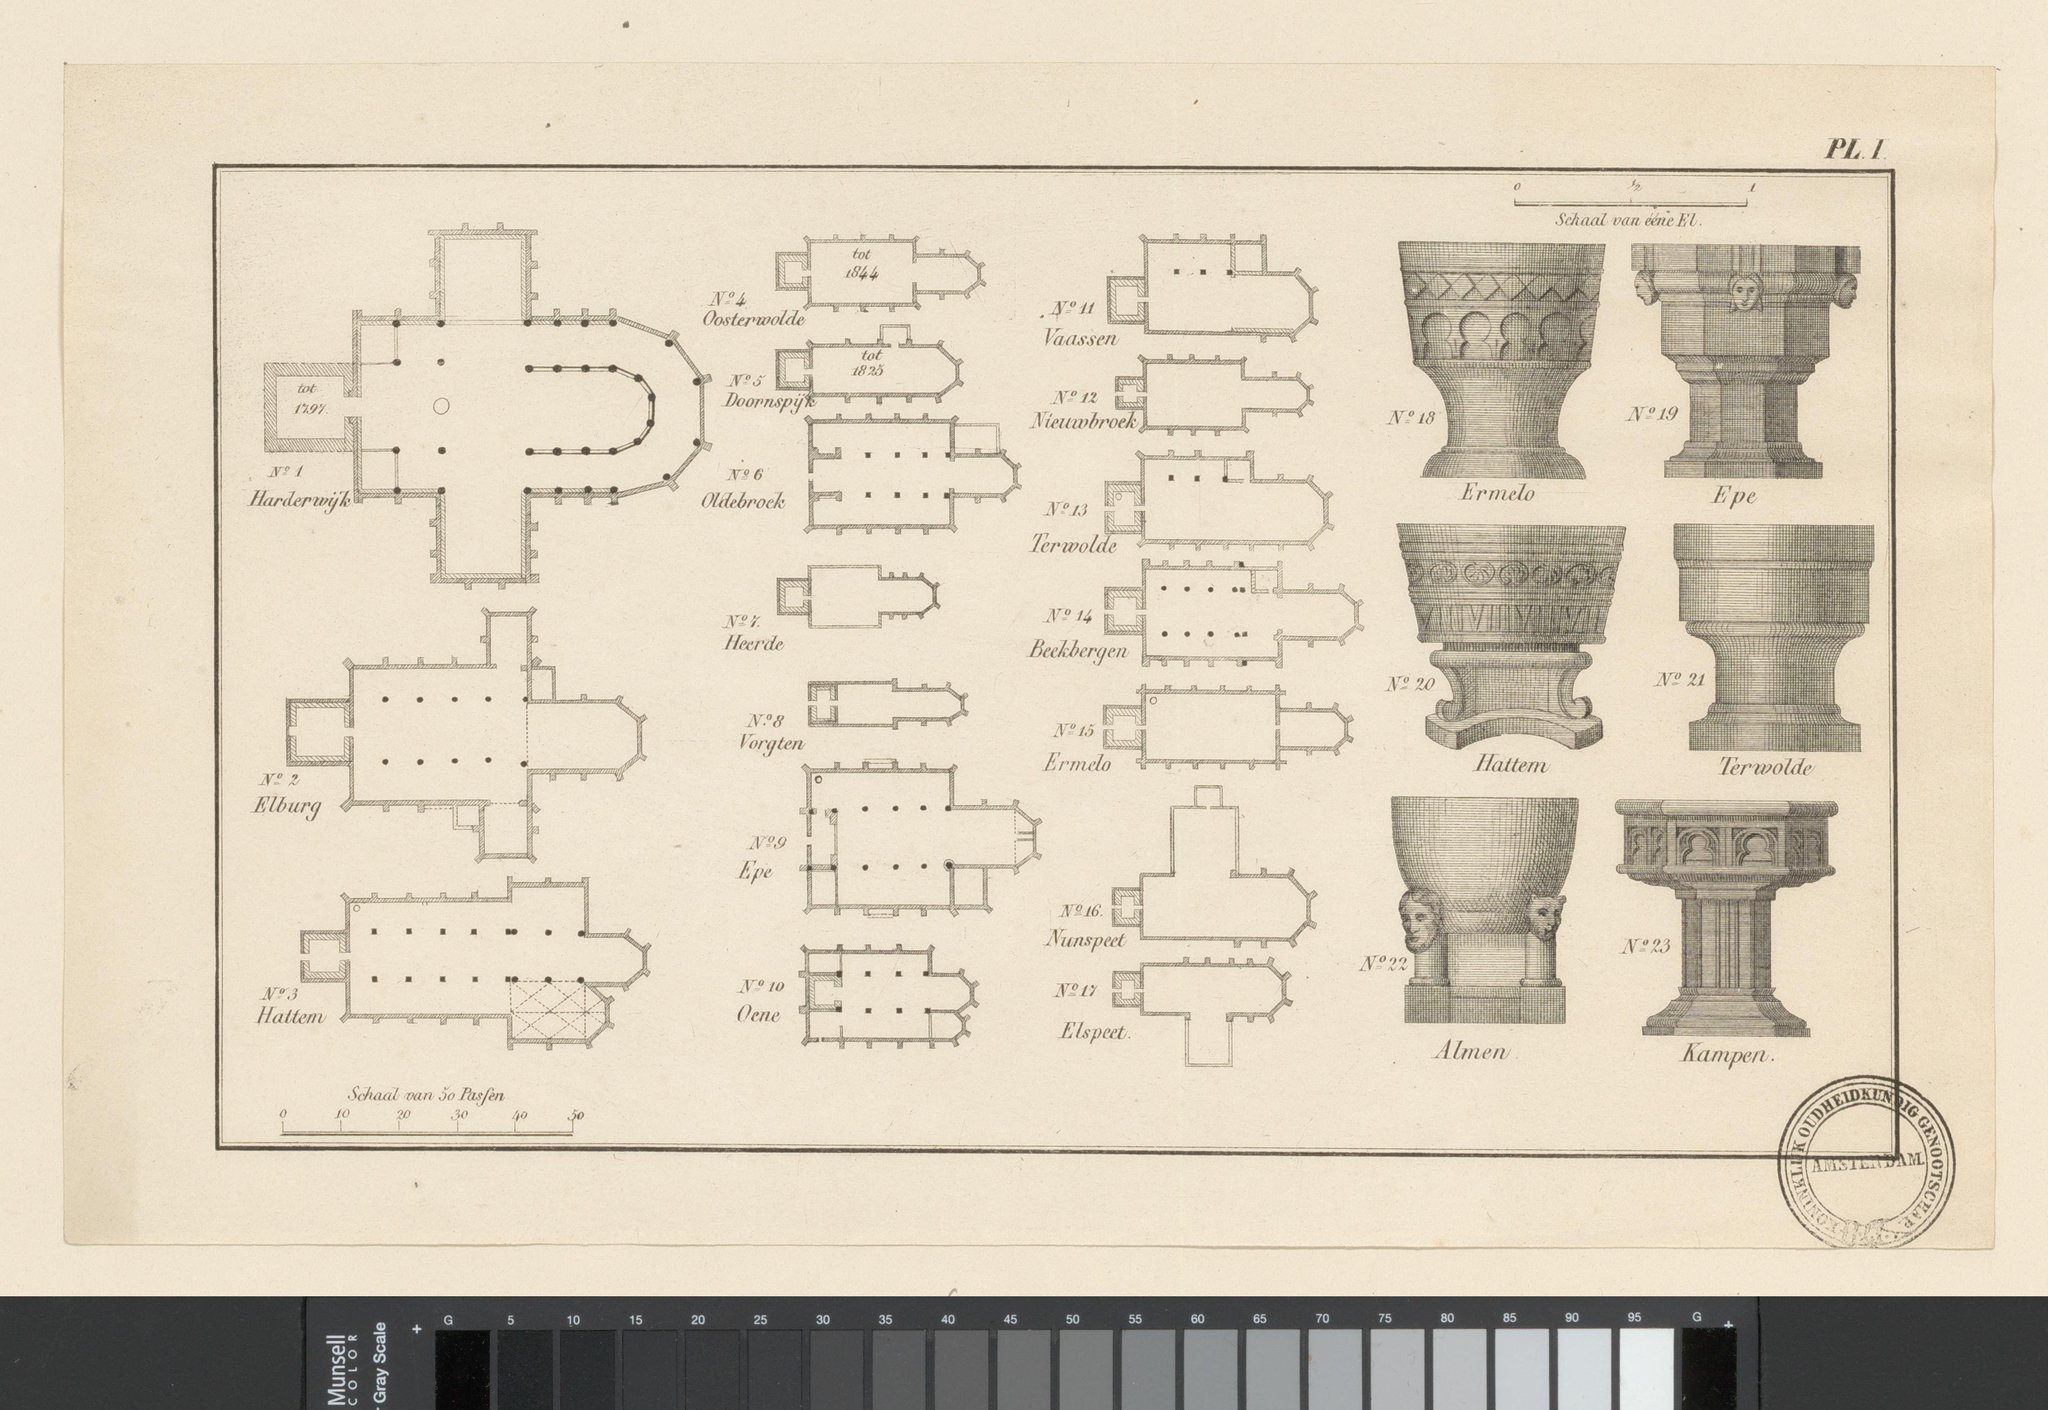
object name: print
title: Plattegronden van kerken en zes doopvonten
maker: leendert springer (i)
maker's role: draughtsman, painter, print maker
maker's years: 1789-1871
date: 1850-1852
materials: paper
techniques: lithograph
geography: leiden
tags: baptismal font, plan ~ architecture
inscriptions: collector's mark: ‘Koninklijk Oudheidkundig Genootschap Amsterdam’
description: Aan de linkerzijde zeventien plattegronden van kerken uit de middeleeuwen. Rechts zes doopvonten. Bij iedere afbeelding staat een nummer en de schaal van de verbeelden objecten op ware grote. Rechtsboven genummerd: PL. I. Onderwerpsrubrieken binnen de Atlas Zeden en Gewoonten: Godsdienst, Roomsch-Katholieken, Processies, Herinneringen.